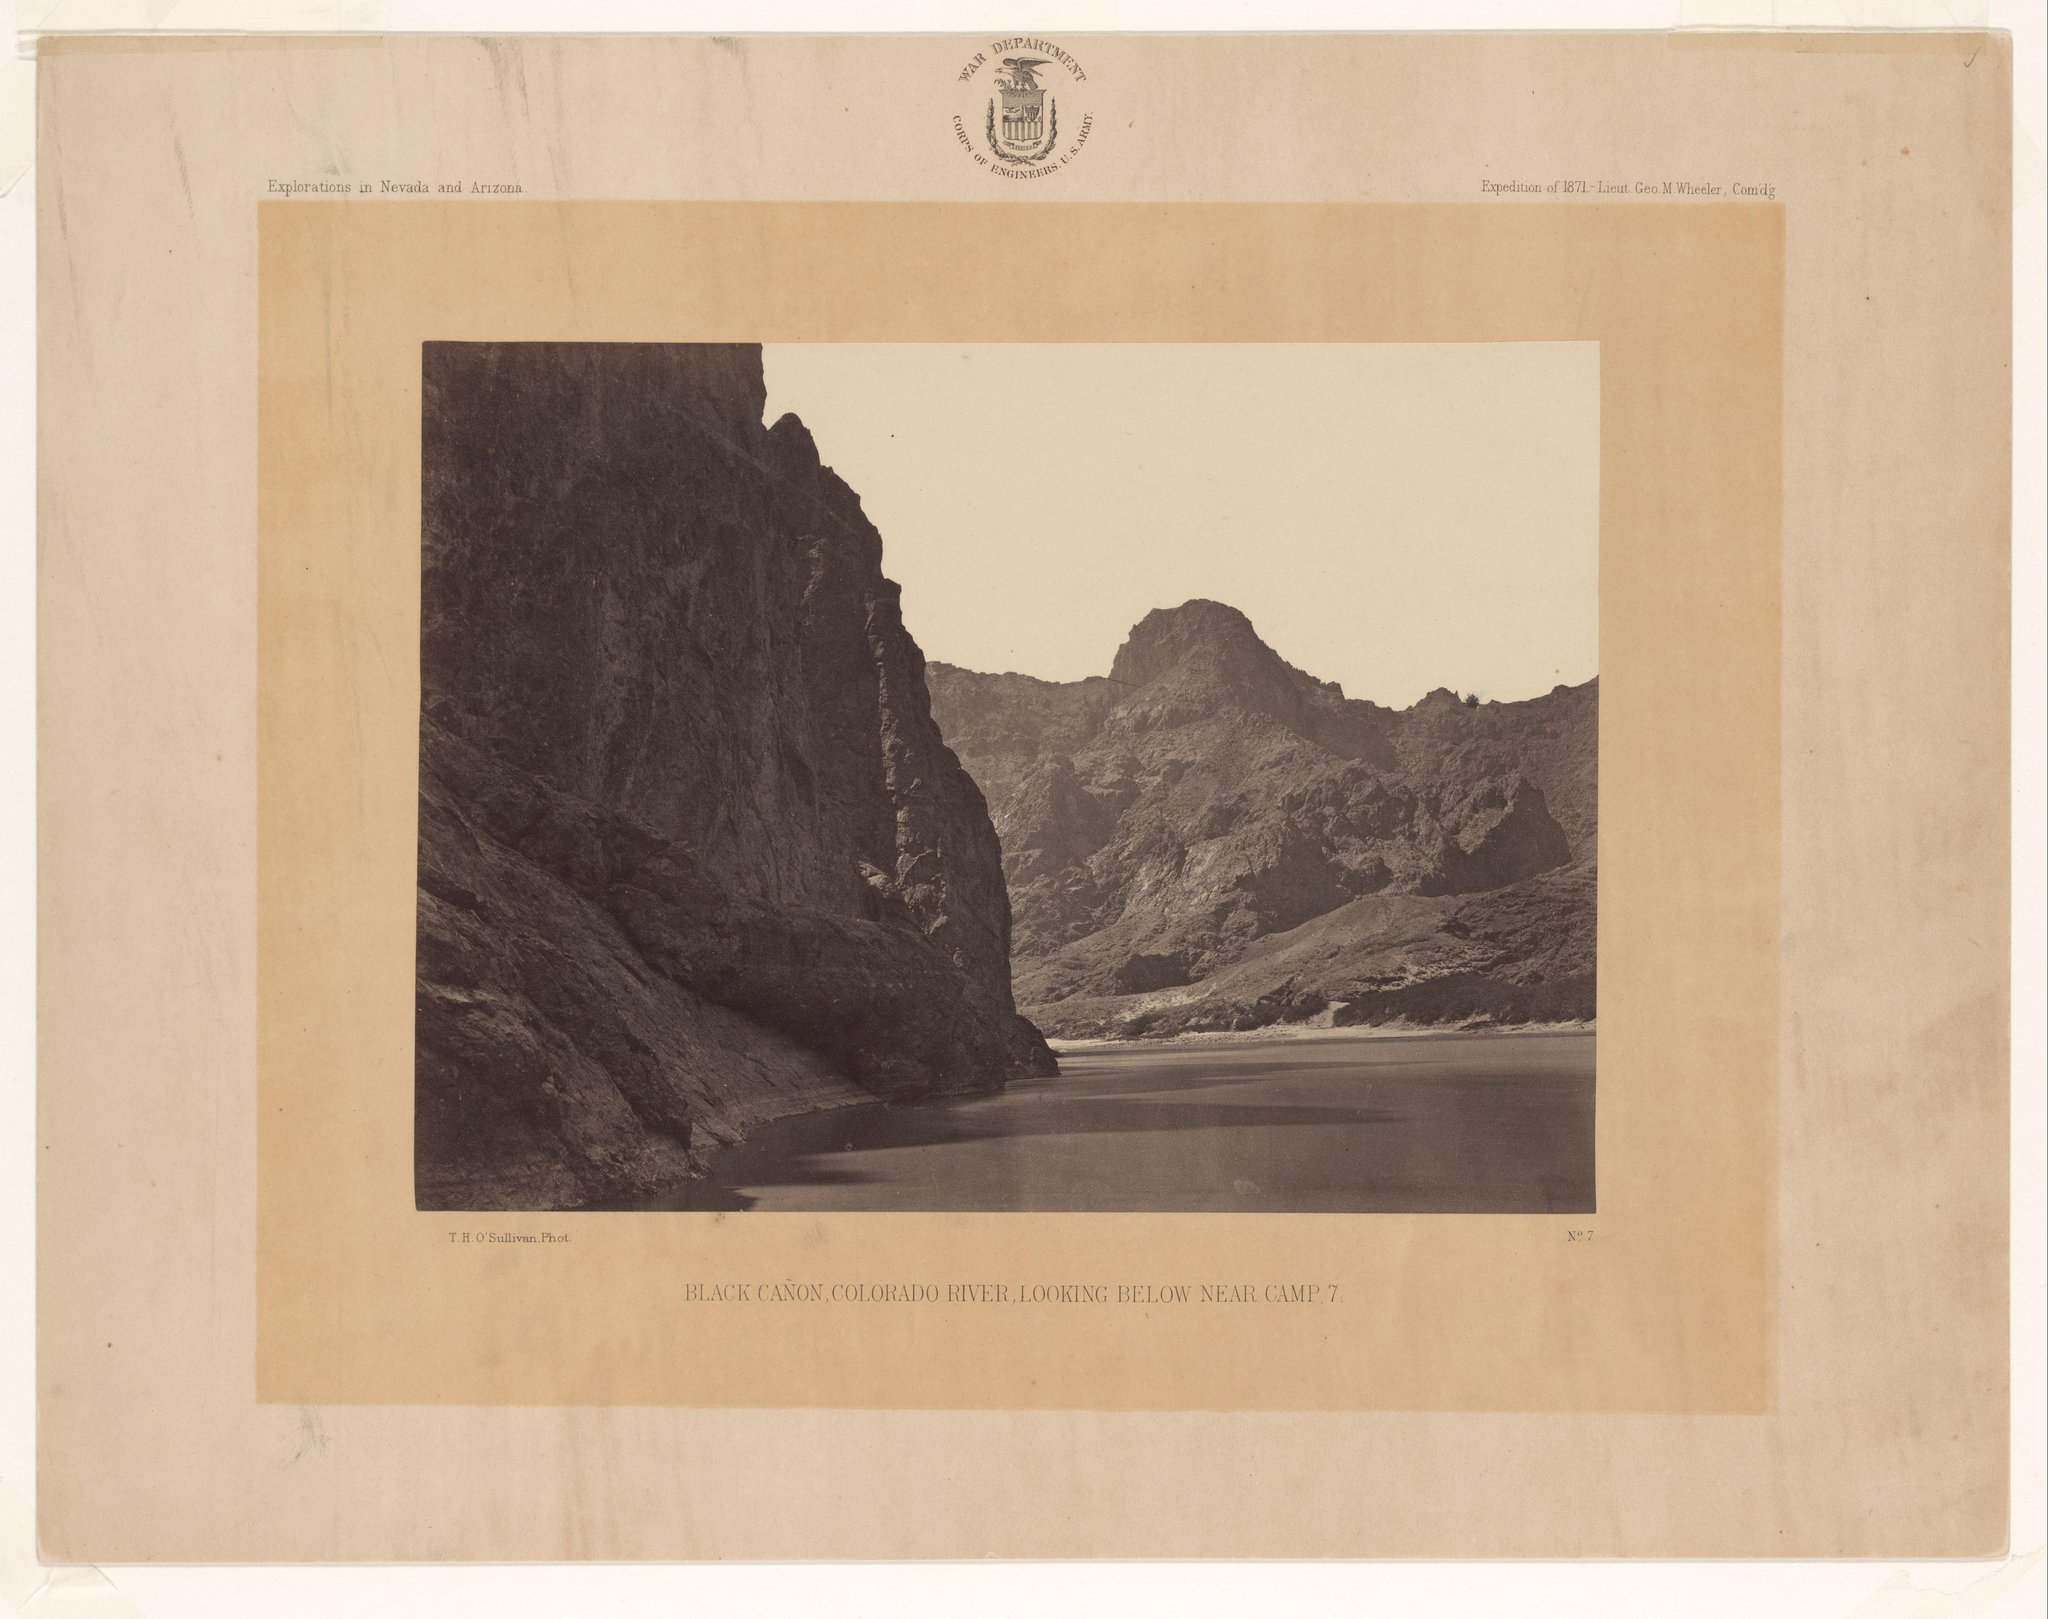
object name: photograph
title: Black Cañon, Colorado-rivier, Verenigde Staten ('Looking Below Near Camp 7')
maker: timothy h. osullivan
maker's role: fotograaf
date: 1871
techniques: albumen print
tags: united states of america